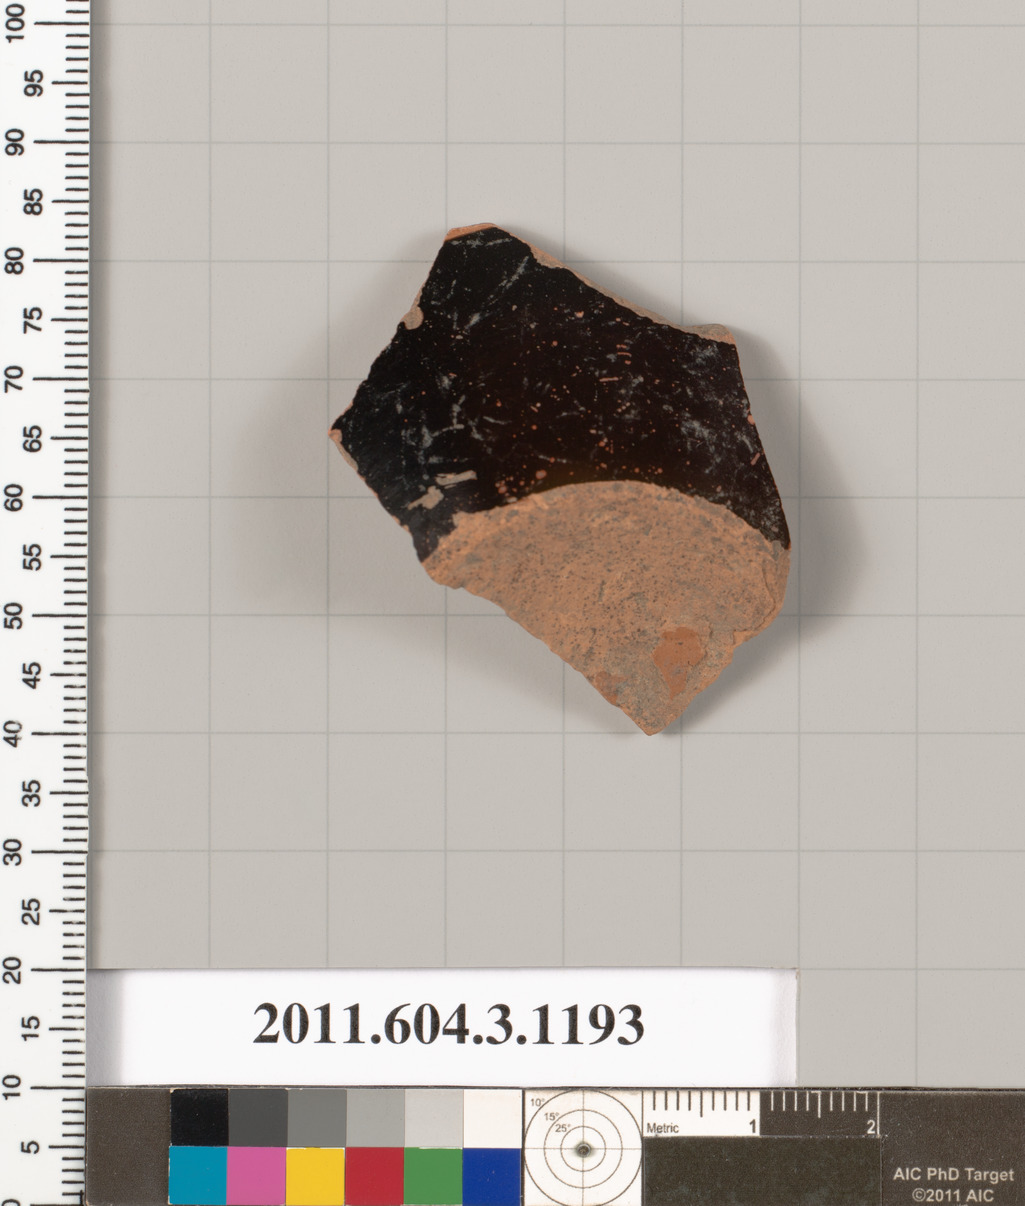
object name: mastoid fragment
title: Terracotta fragment of a mastoid (drinking cup with narrow base)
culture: greek, attic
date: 534-468 BCE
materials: terracotta